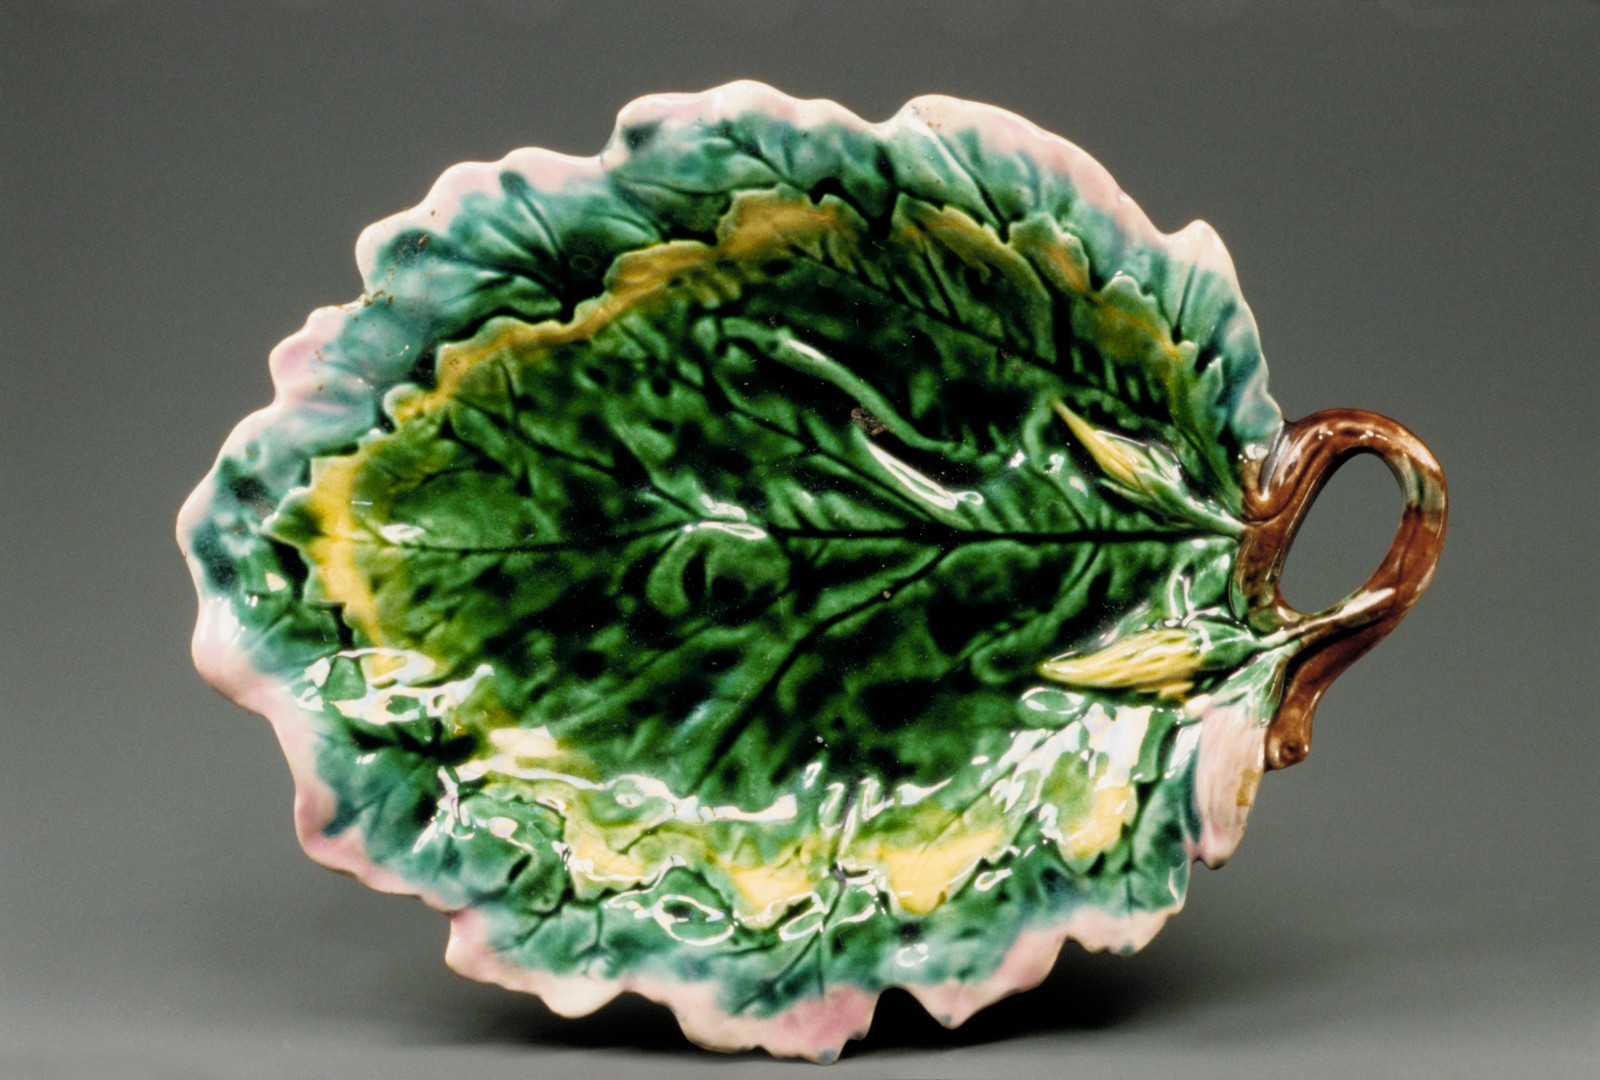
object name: bread plate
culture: american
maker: griffen, smith and hill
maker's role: maker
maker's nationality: american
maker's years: 1880-1889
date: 1880-1889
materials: earthenware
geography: united states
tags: leaves